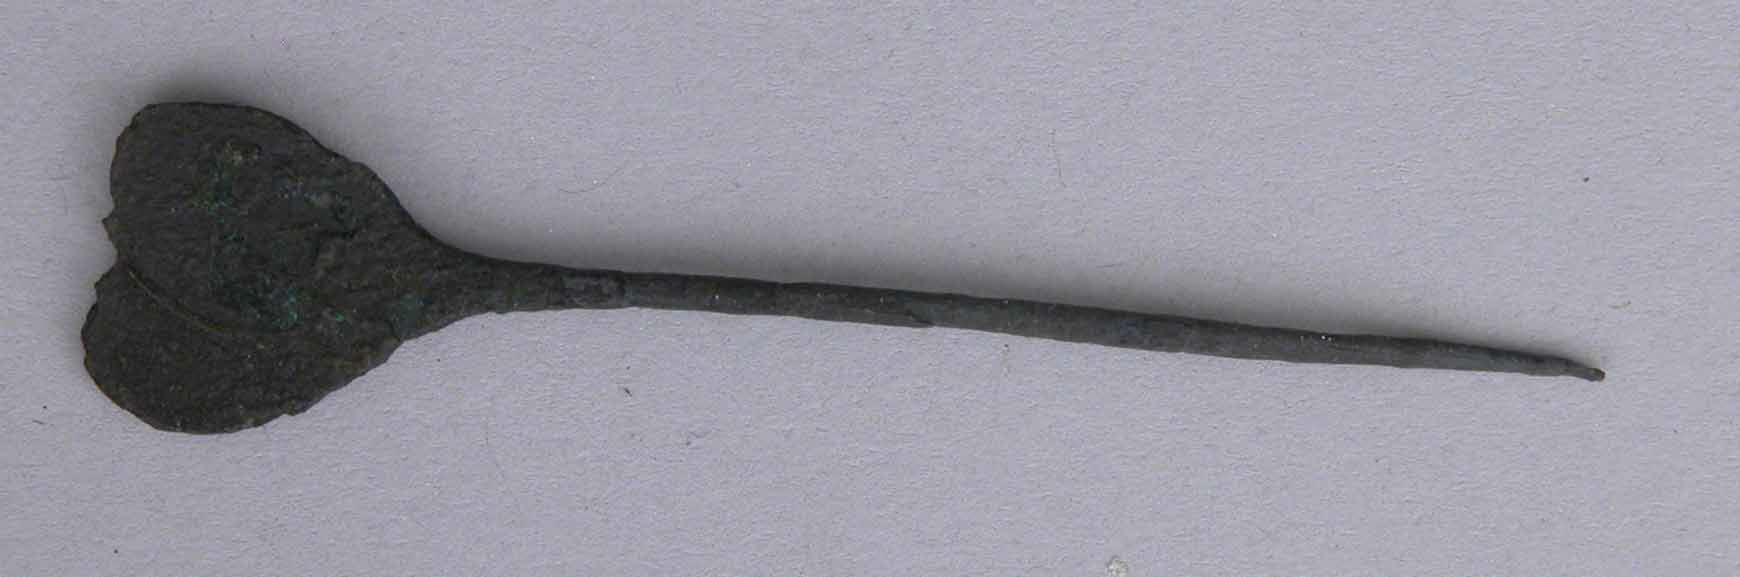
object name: hair pin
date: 501-600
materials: bronze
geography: egypt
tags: pins